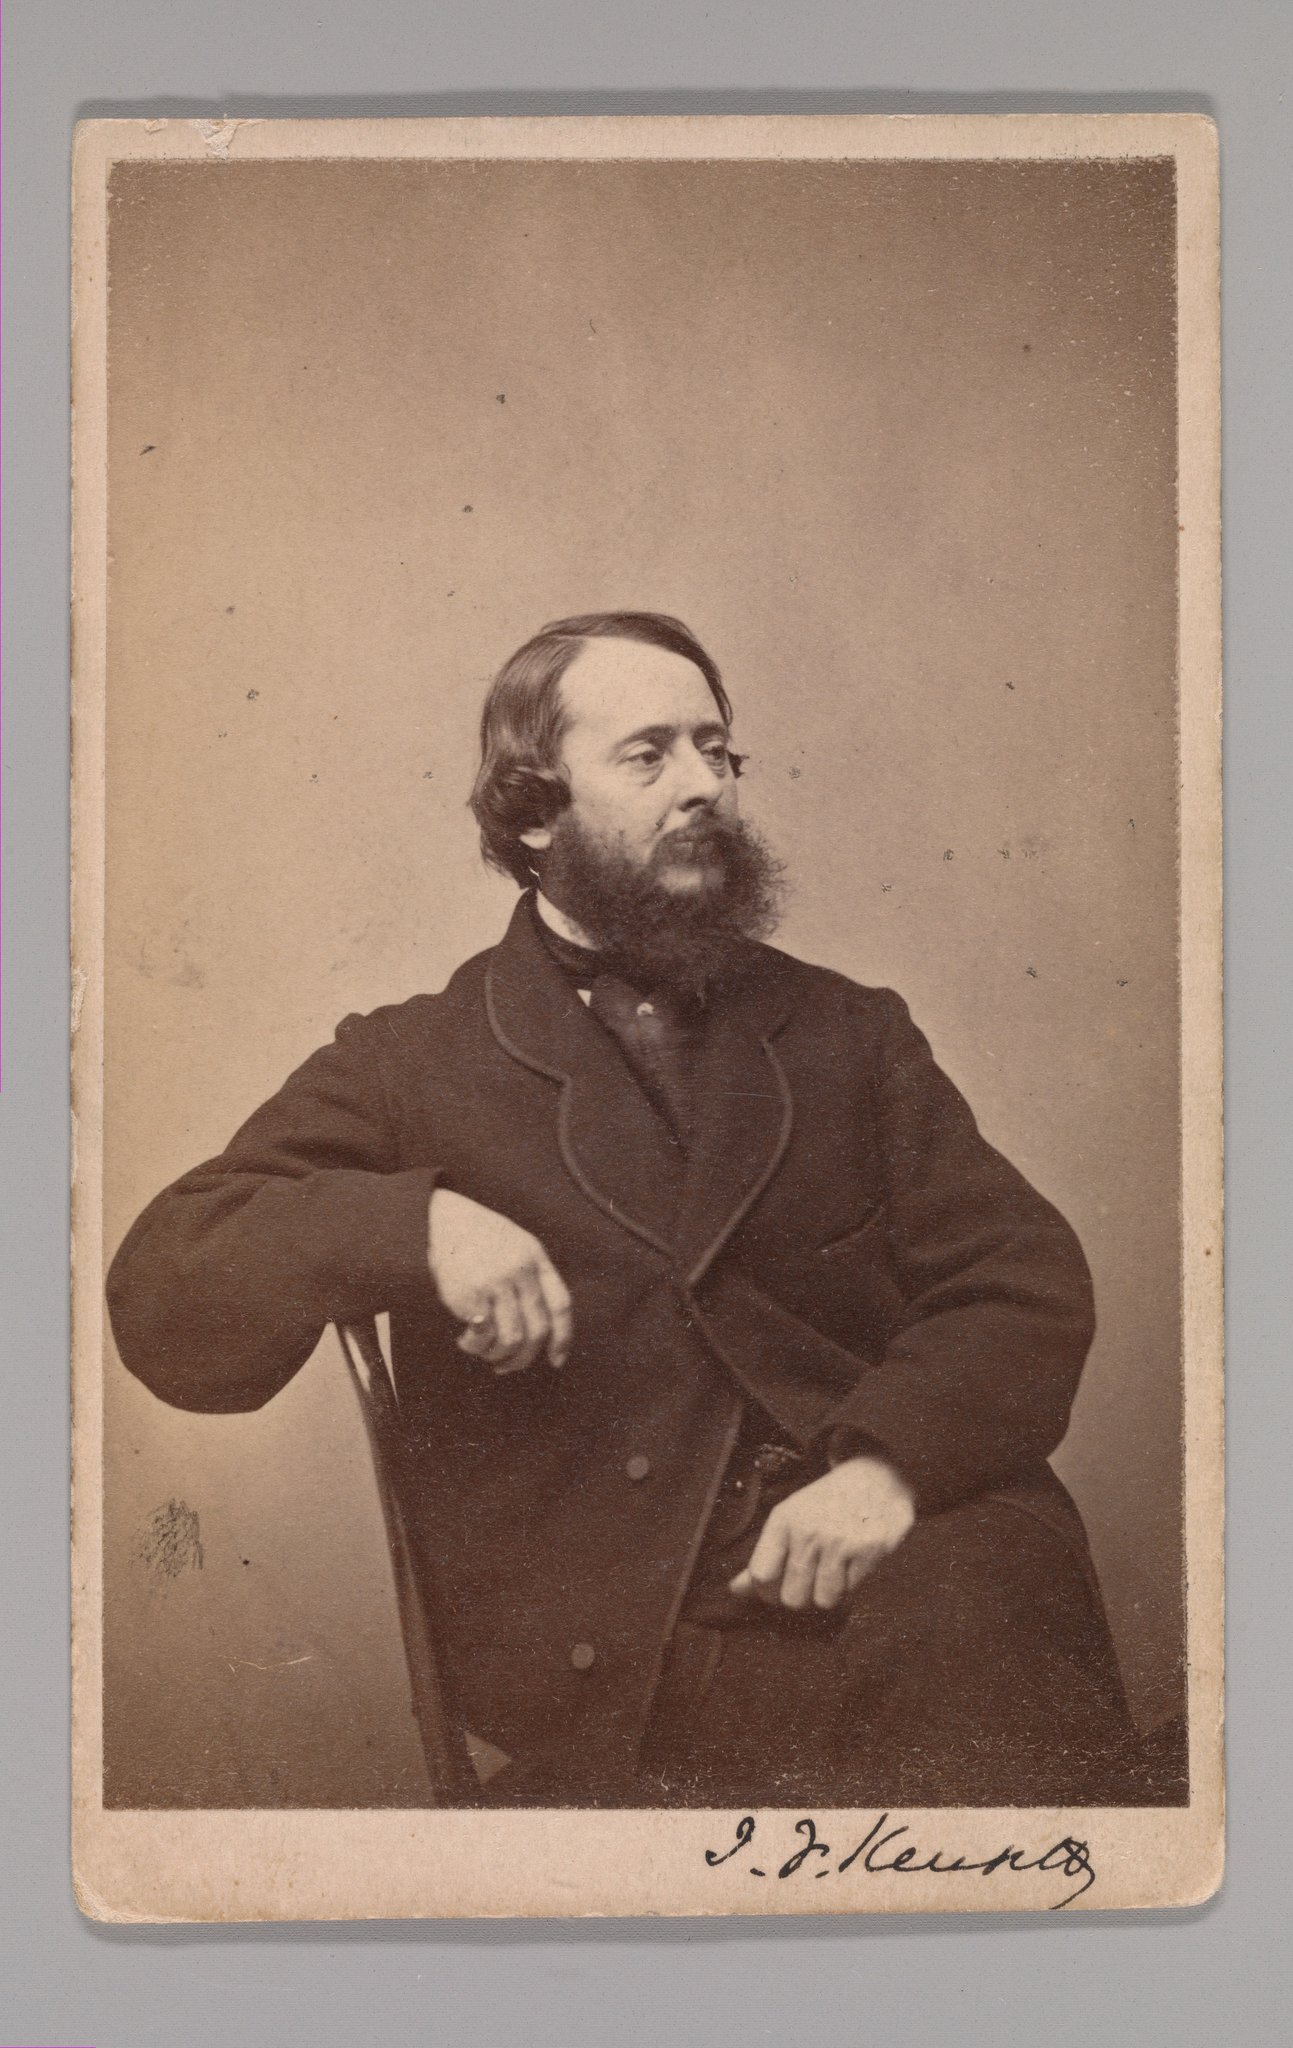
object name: carte de visite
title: [John Frederick Kensett]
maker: george gardner rockwood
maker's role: fotograaf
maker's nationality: american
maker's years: 1832-1911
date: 1860-1869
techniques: albumen silver print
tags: men,portraits